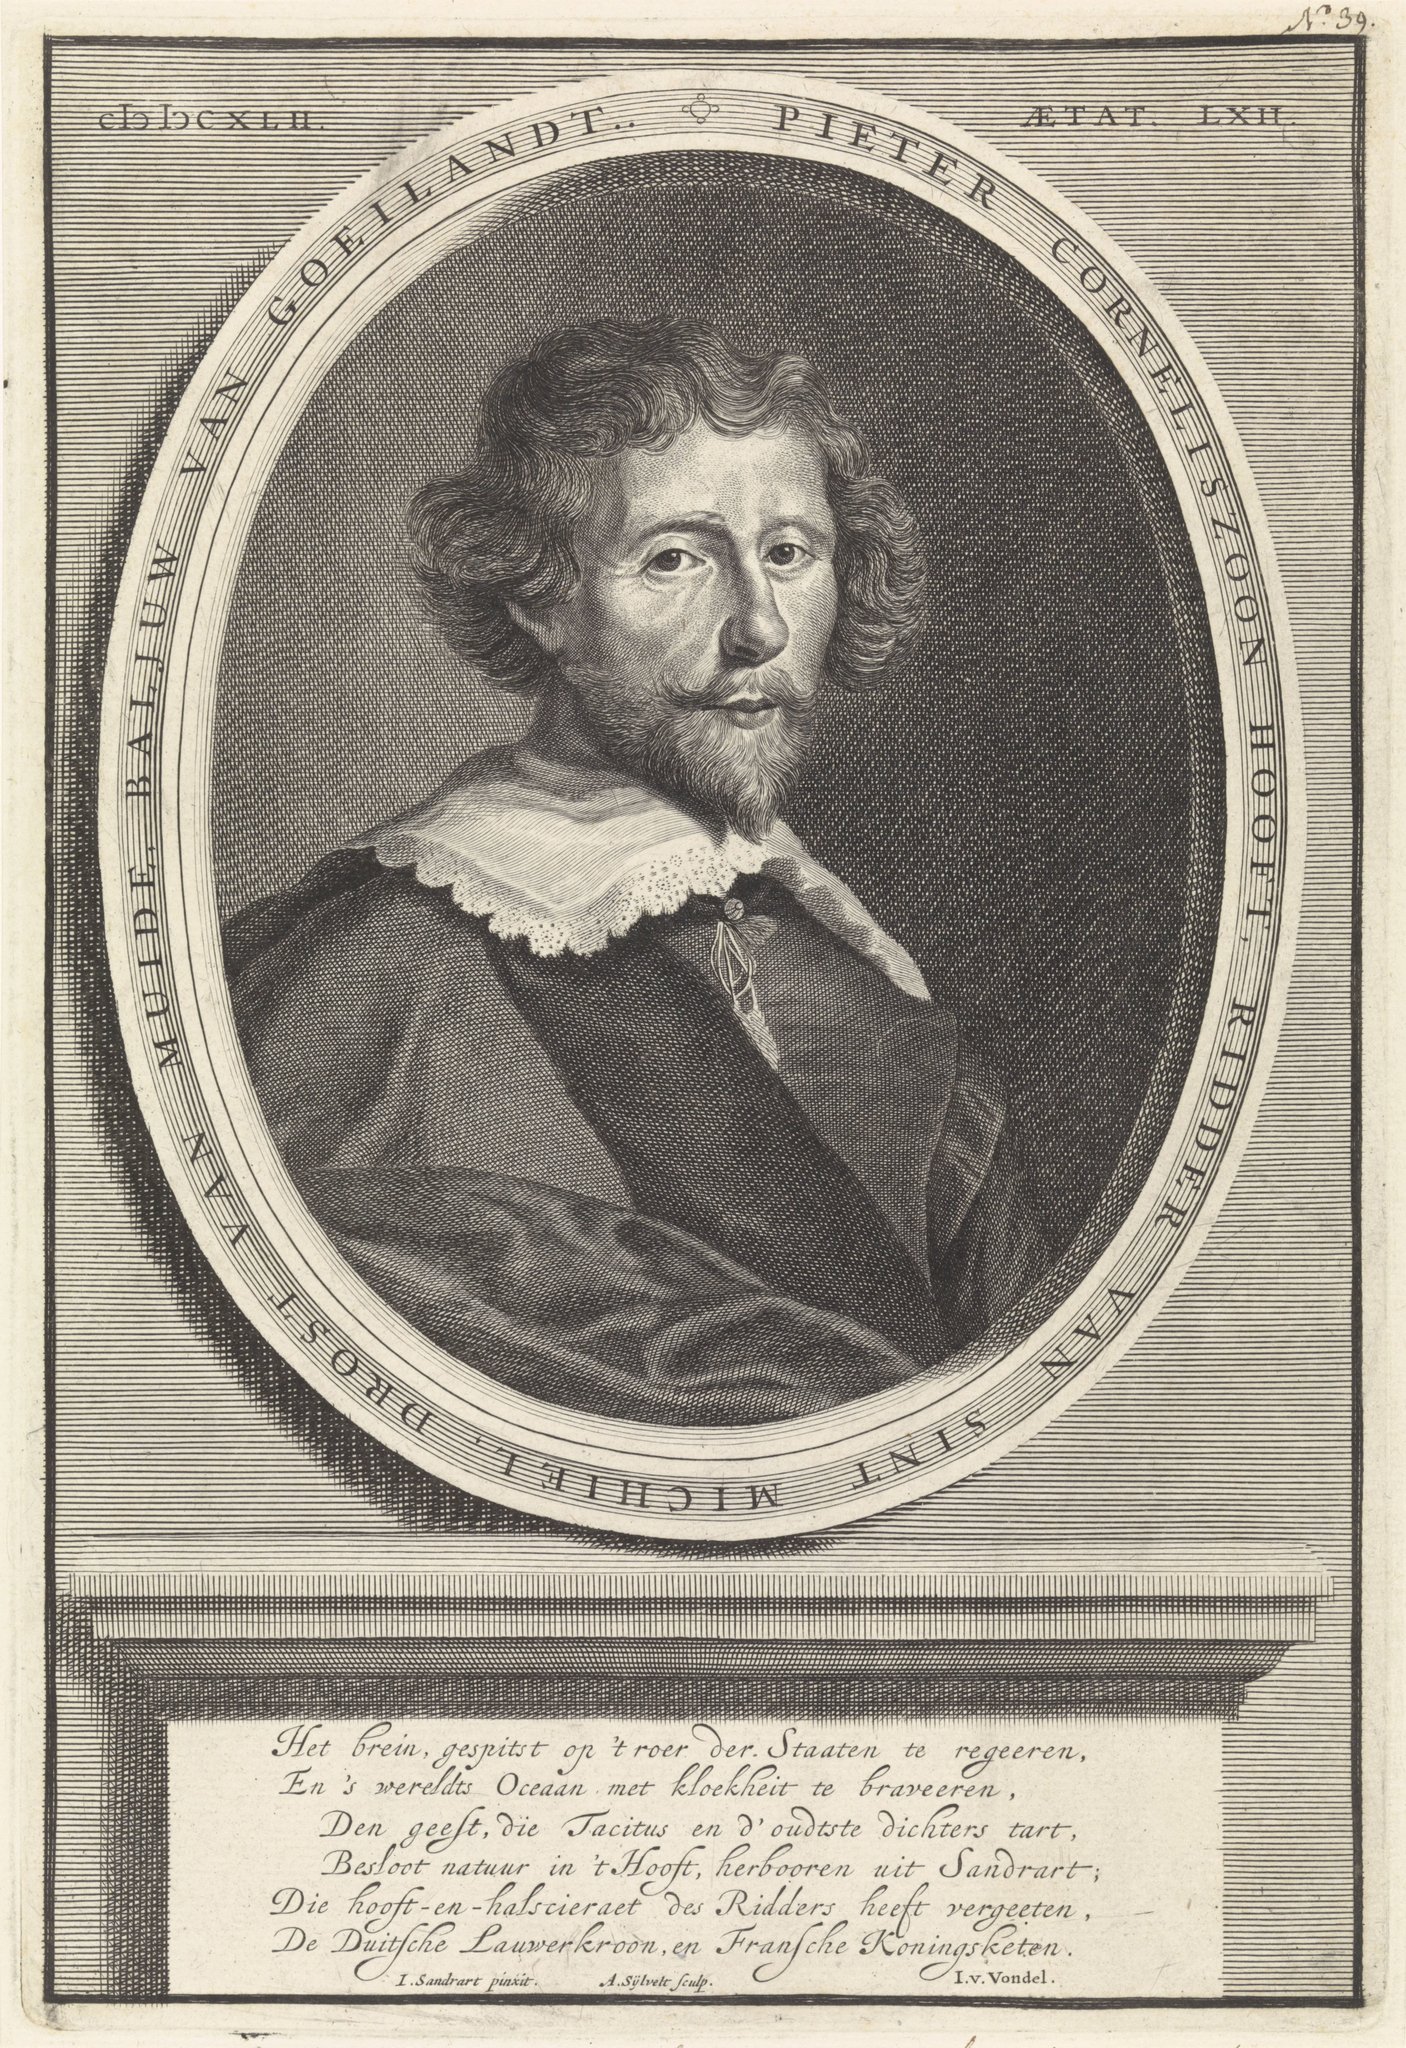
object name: print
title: Portret van Pieter Cornelisz. Hooft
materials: paper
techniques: engraving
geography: amsterdam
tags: amsterdam, pieter corneliszoon hooft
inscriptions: collector's mark: Lugt 2228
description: Portret van Pieter Cornelisz. Hooft, dichter, dramaschrijver en historicus op 62-jarige leeftijd. Op de sokkel een zesregelig gedicht van Vondel.